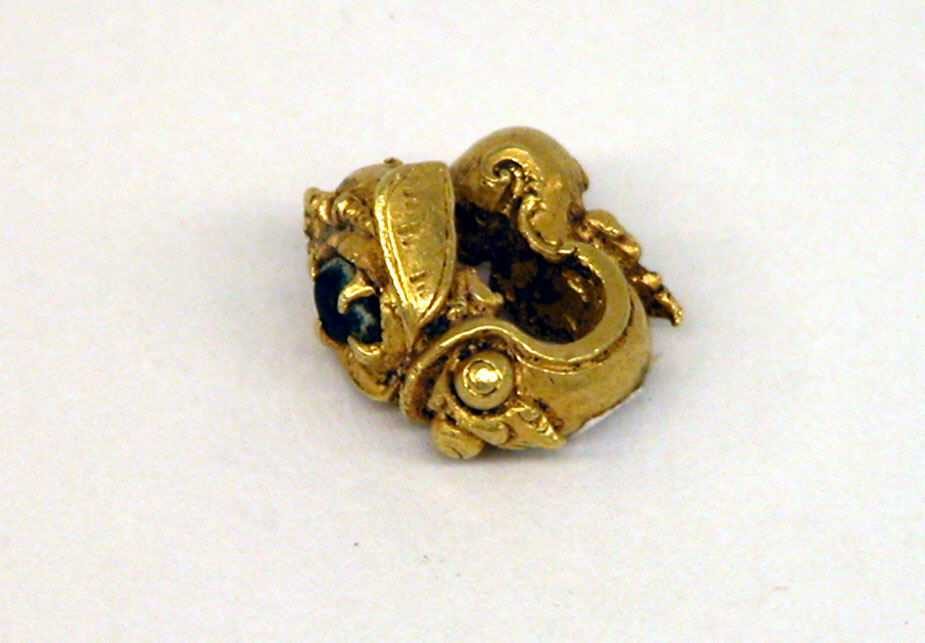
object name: ear ornament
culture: indonesian, javanese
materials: gold